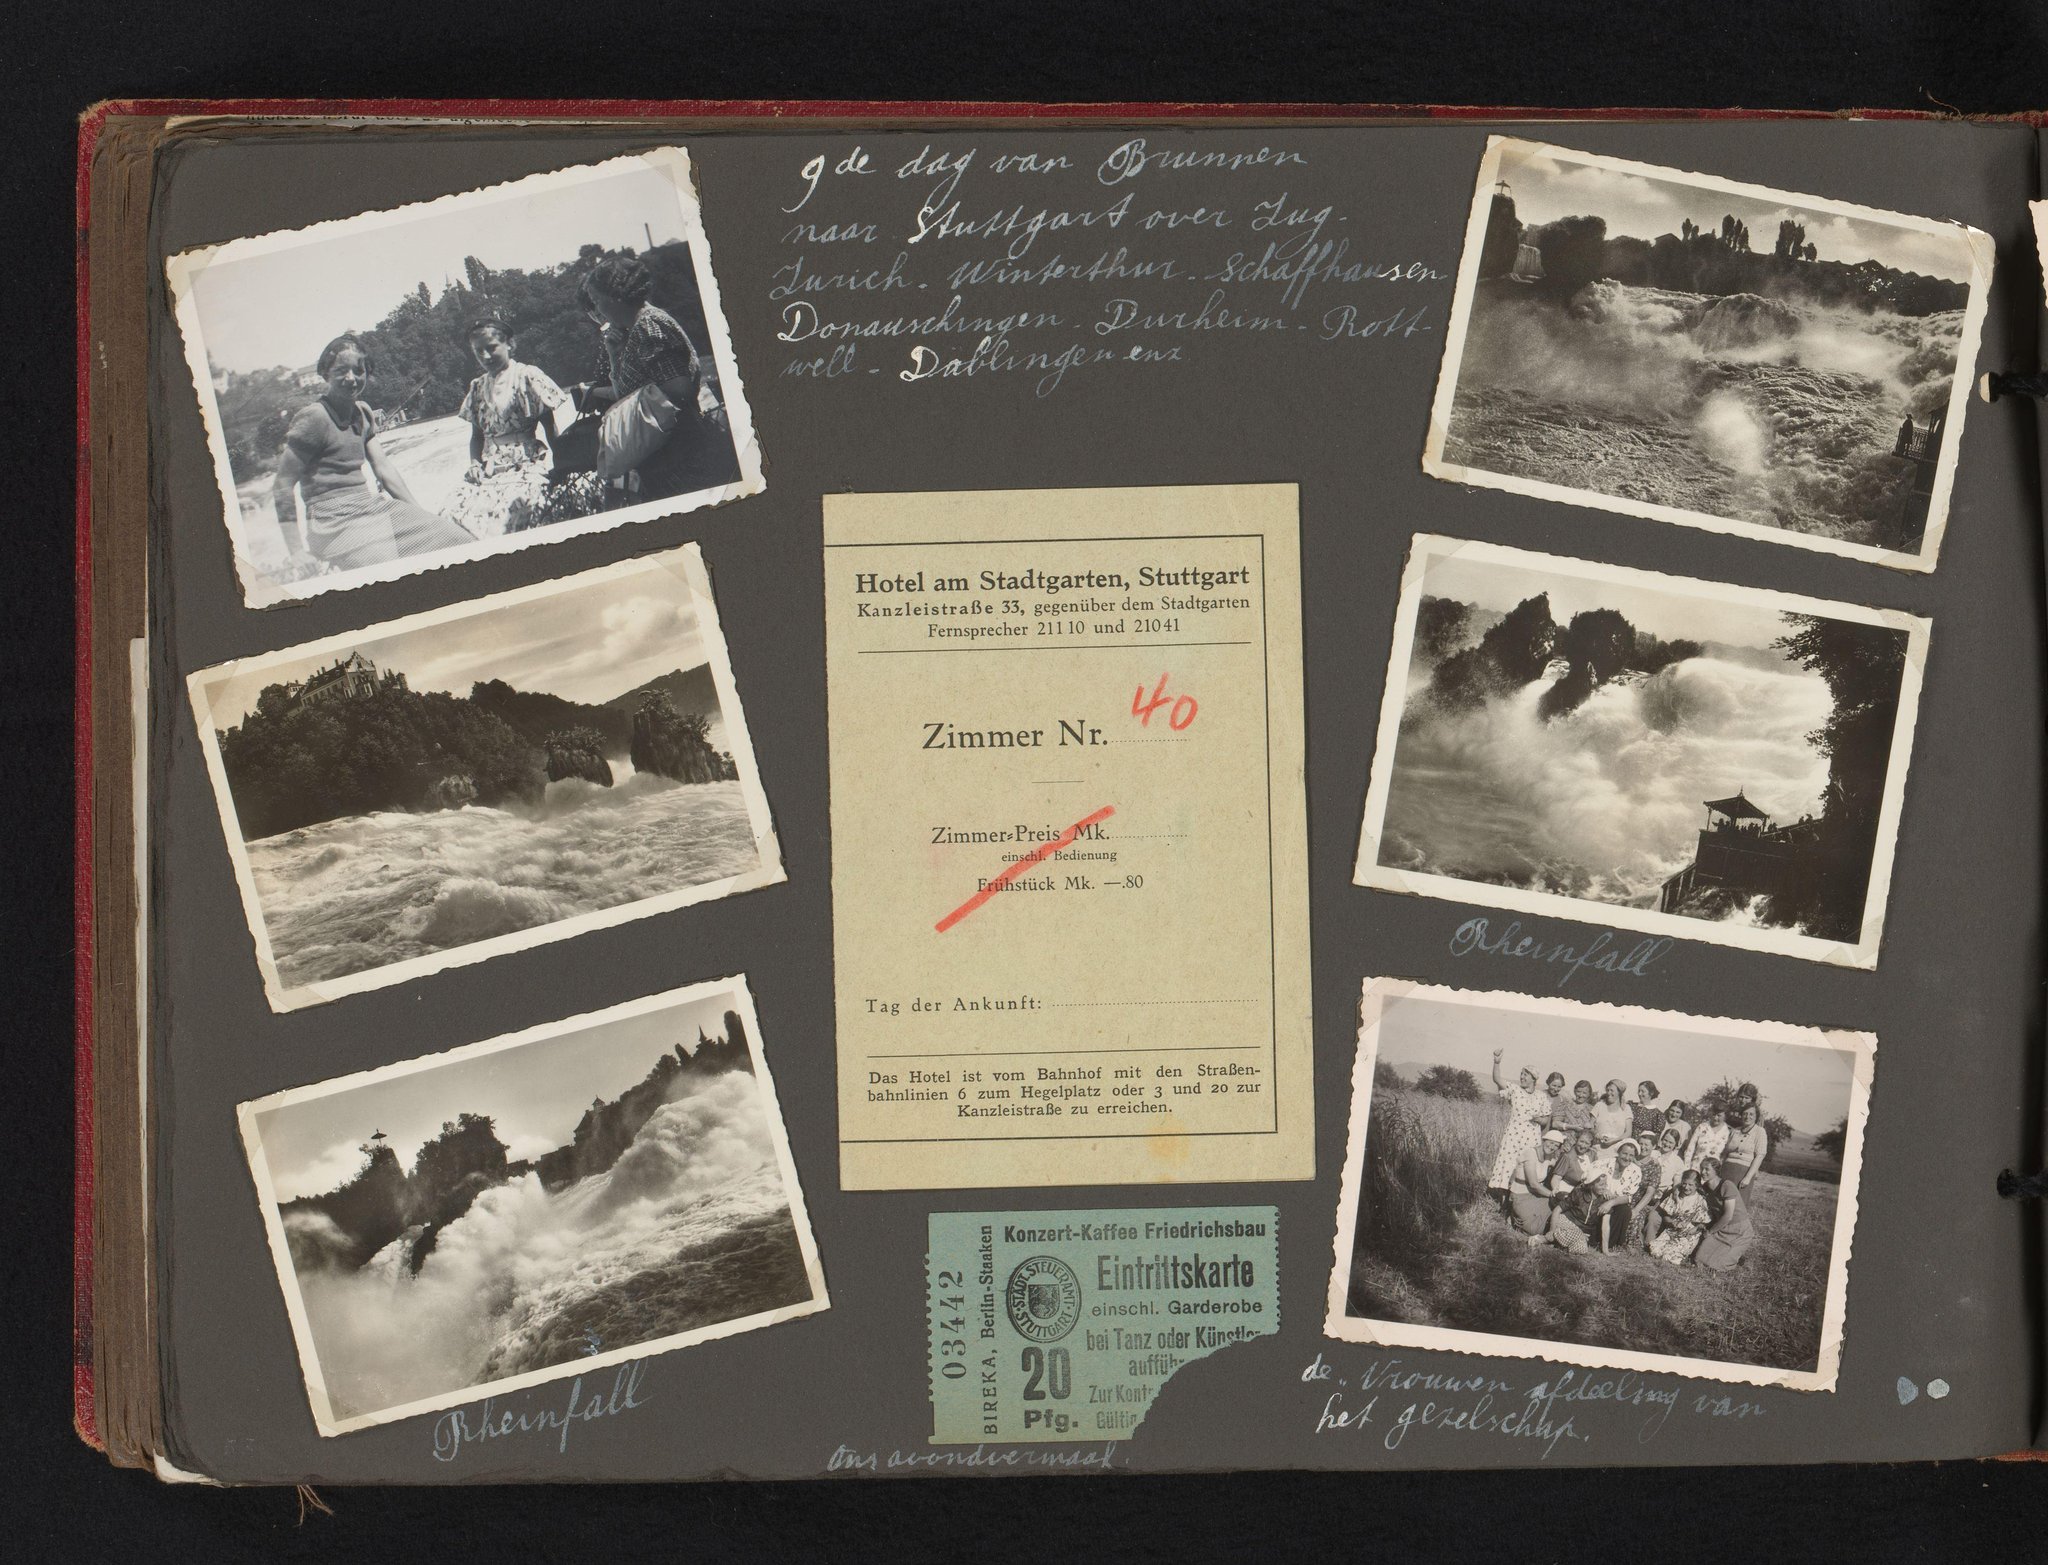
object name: album leaf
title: 9de dag van Brunnen naar Stuttgart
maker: Anonymous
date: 1908-1937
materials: paper, photographic support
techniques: gelatin silver print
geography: switzerland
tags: waterfall, outing, pleasure trip, switzerland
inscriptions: inscription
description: Albumblad met vier gekochte foto's van de Rheinfall, twee foto's van de vrouwen in de reisgroep, het kaartje voor het hotel in Stuttgart en een toegangskaartje voor een koffieconcert. Verslag van een elfdaagse groepsreis per autobus naar Zwitserland van 2 tot en met 12 augustus 1937. Onderdeel van het reisalbum van de familie Van den Broek 1935-1937.